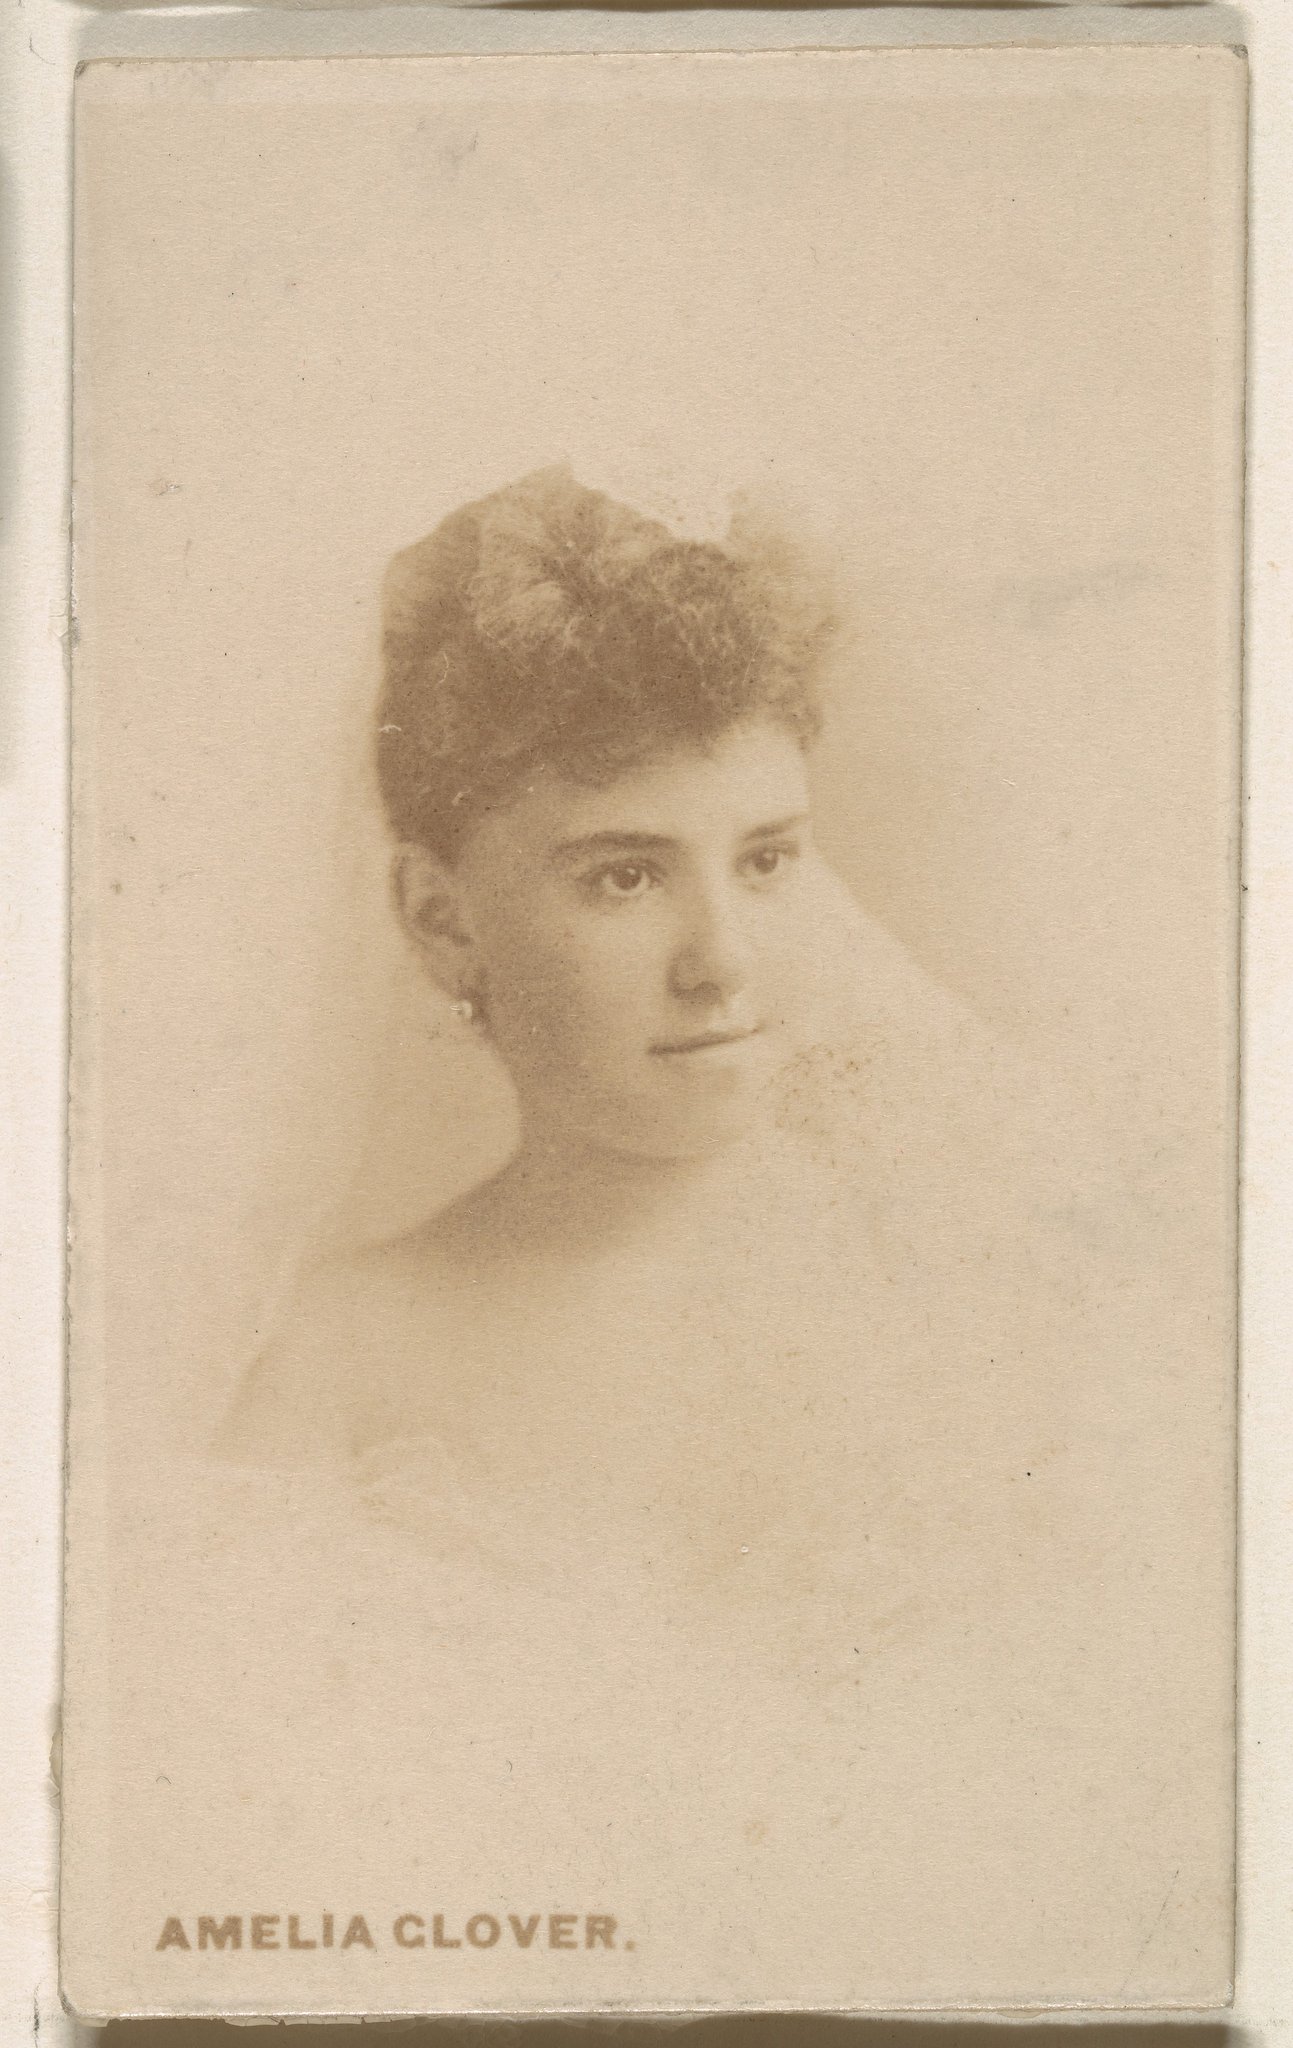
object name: photograph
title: Amelia Glover, from the Actresses series (N246), Type 1, issued by Kinney Brothers to promote Sporting Extra Cigarettes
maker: kinney brothers tobacco company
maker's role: publisher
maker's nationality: american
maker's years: 1869-2011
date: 1890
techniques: albumen silver print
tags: portraits,women,actresses